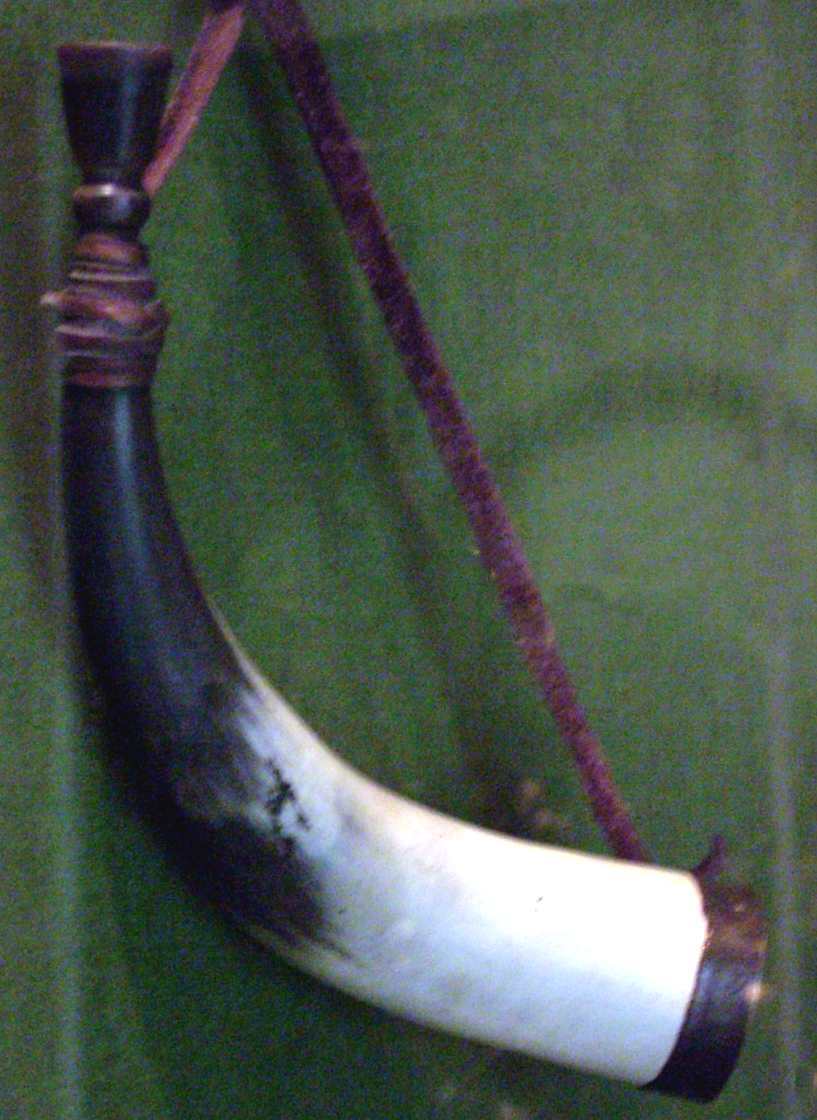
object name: hunting horn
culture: european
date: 1800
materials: horn